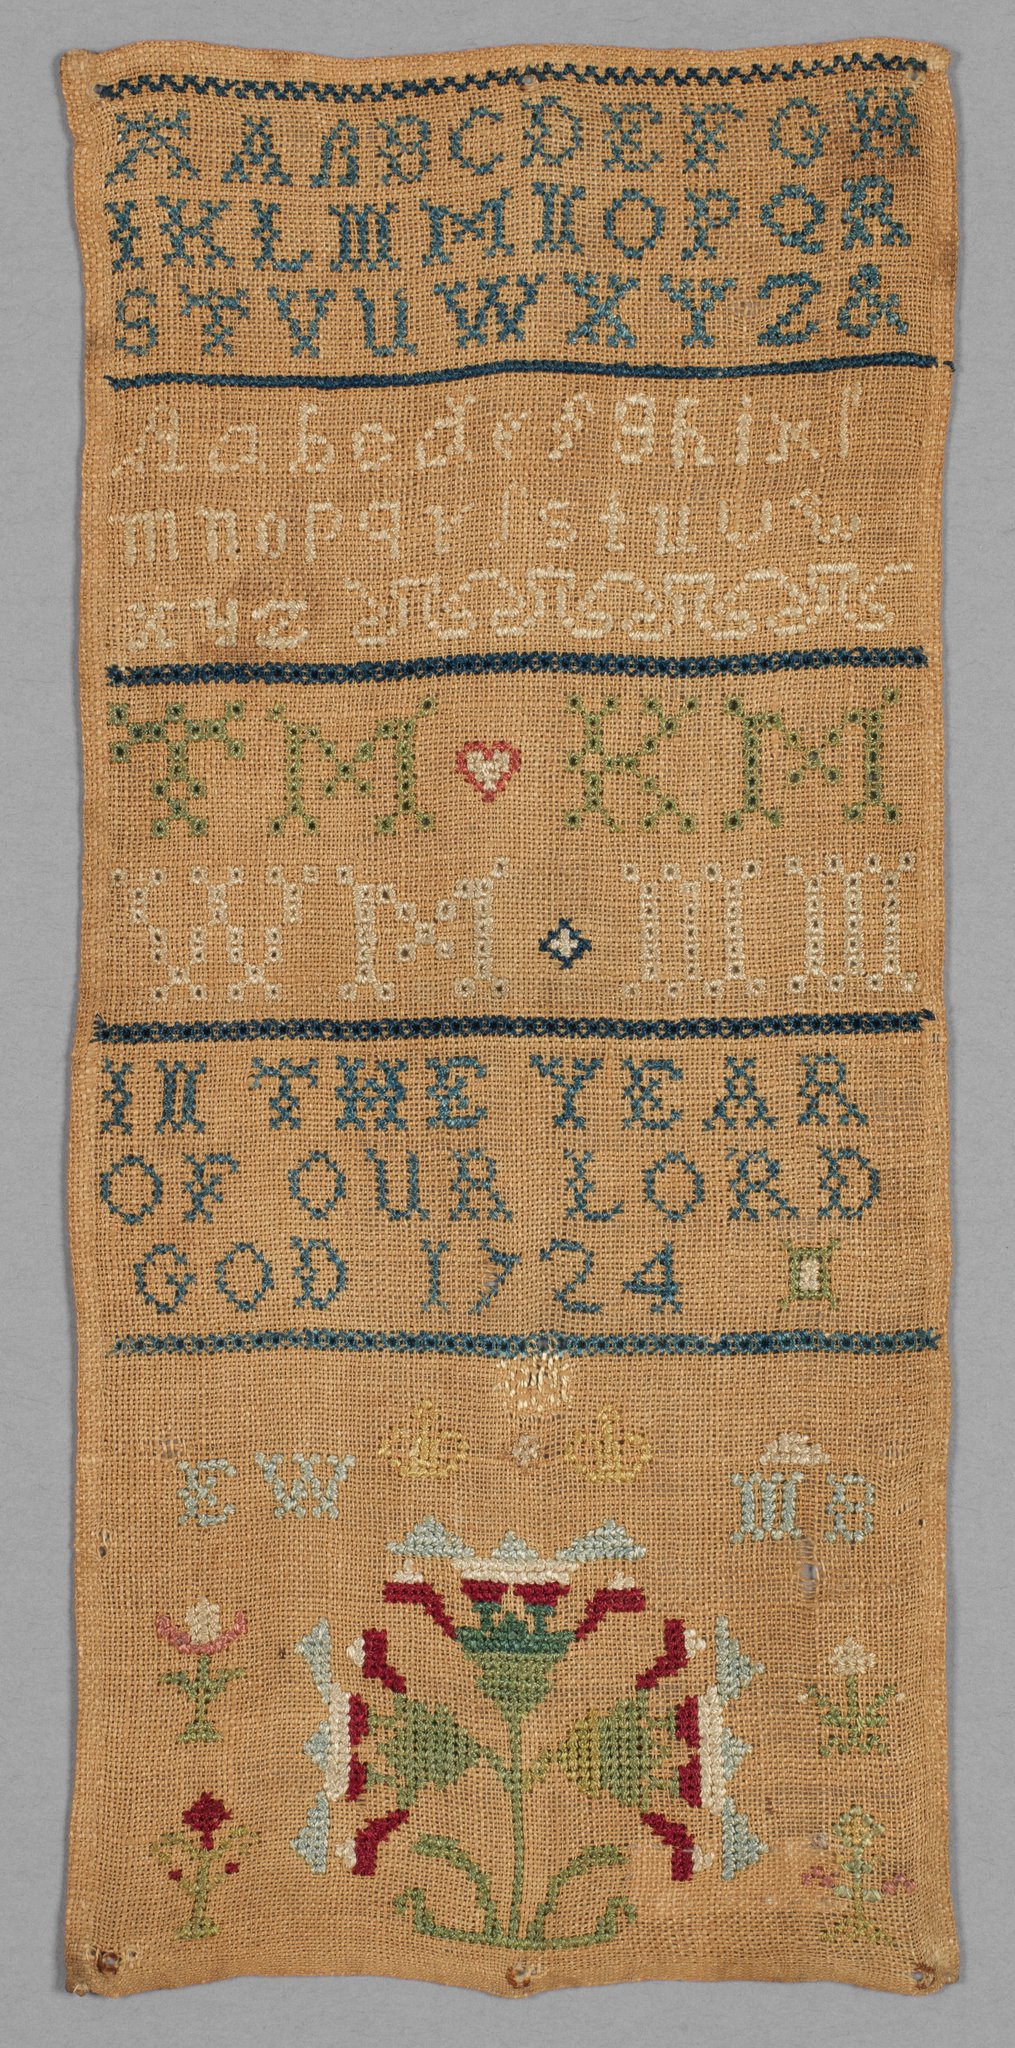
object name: sampler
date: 1724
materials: linen, silk